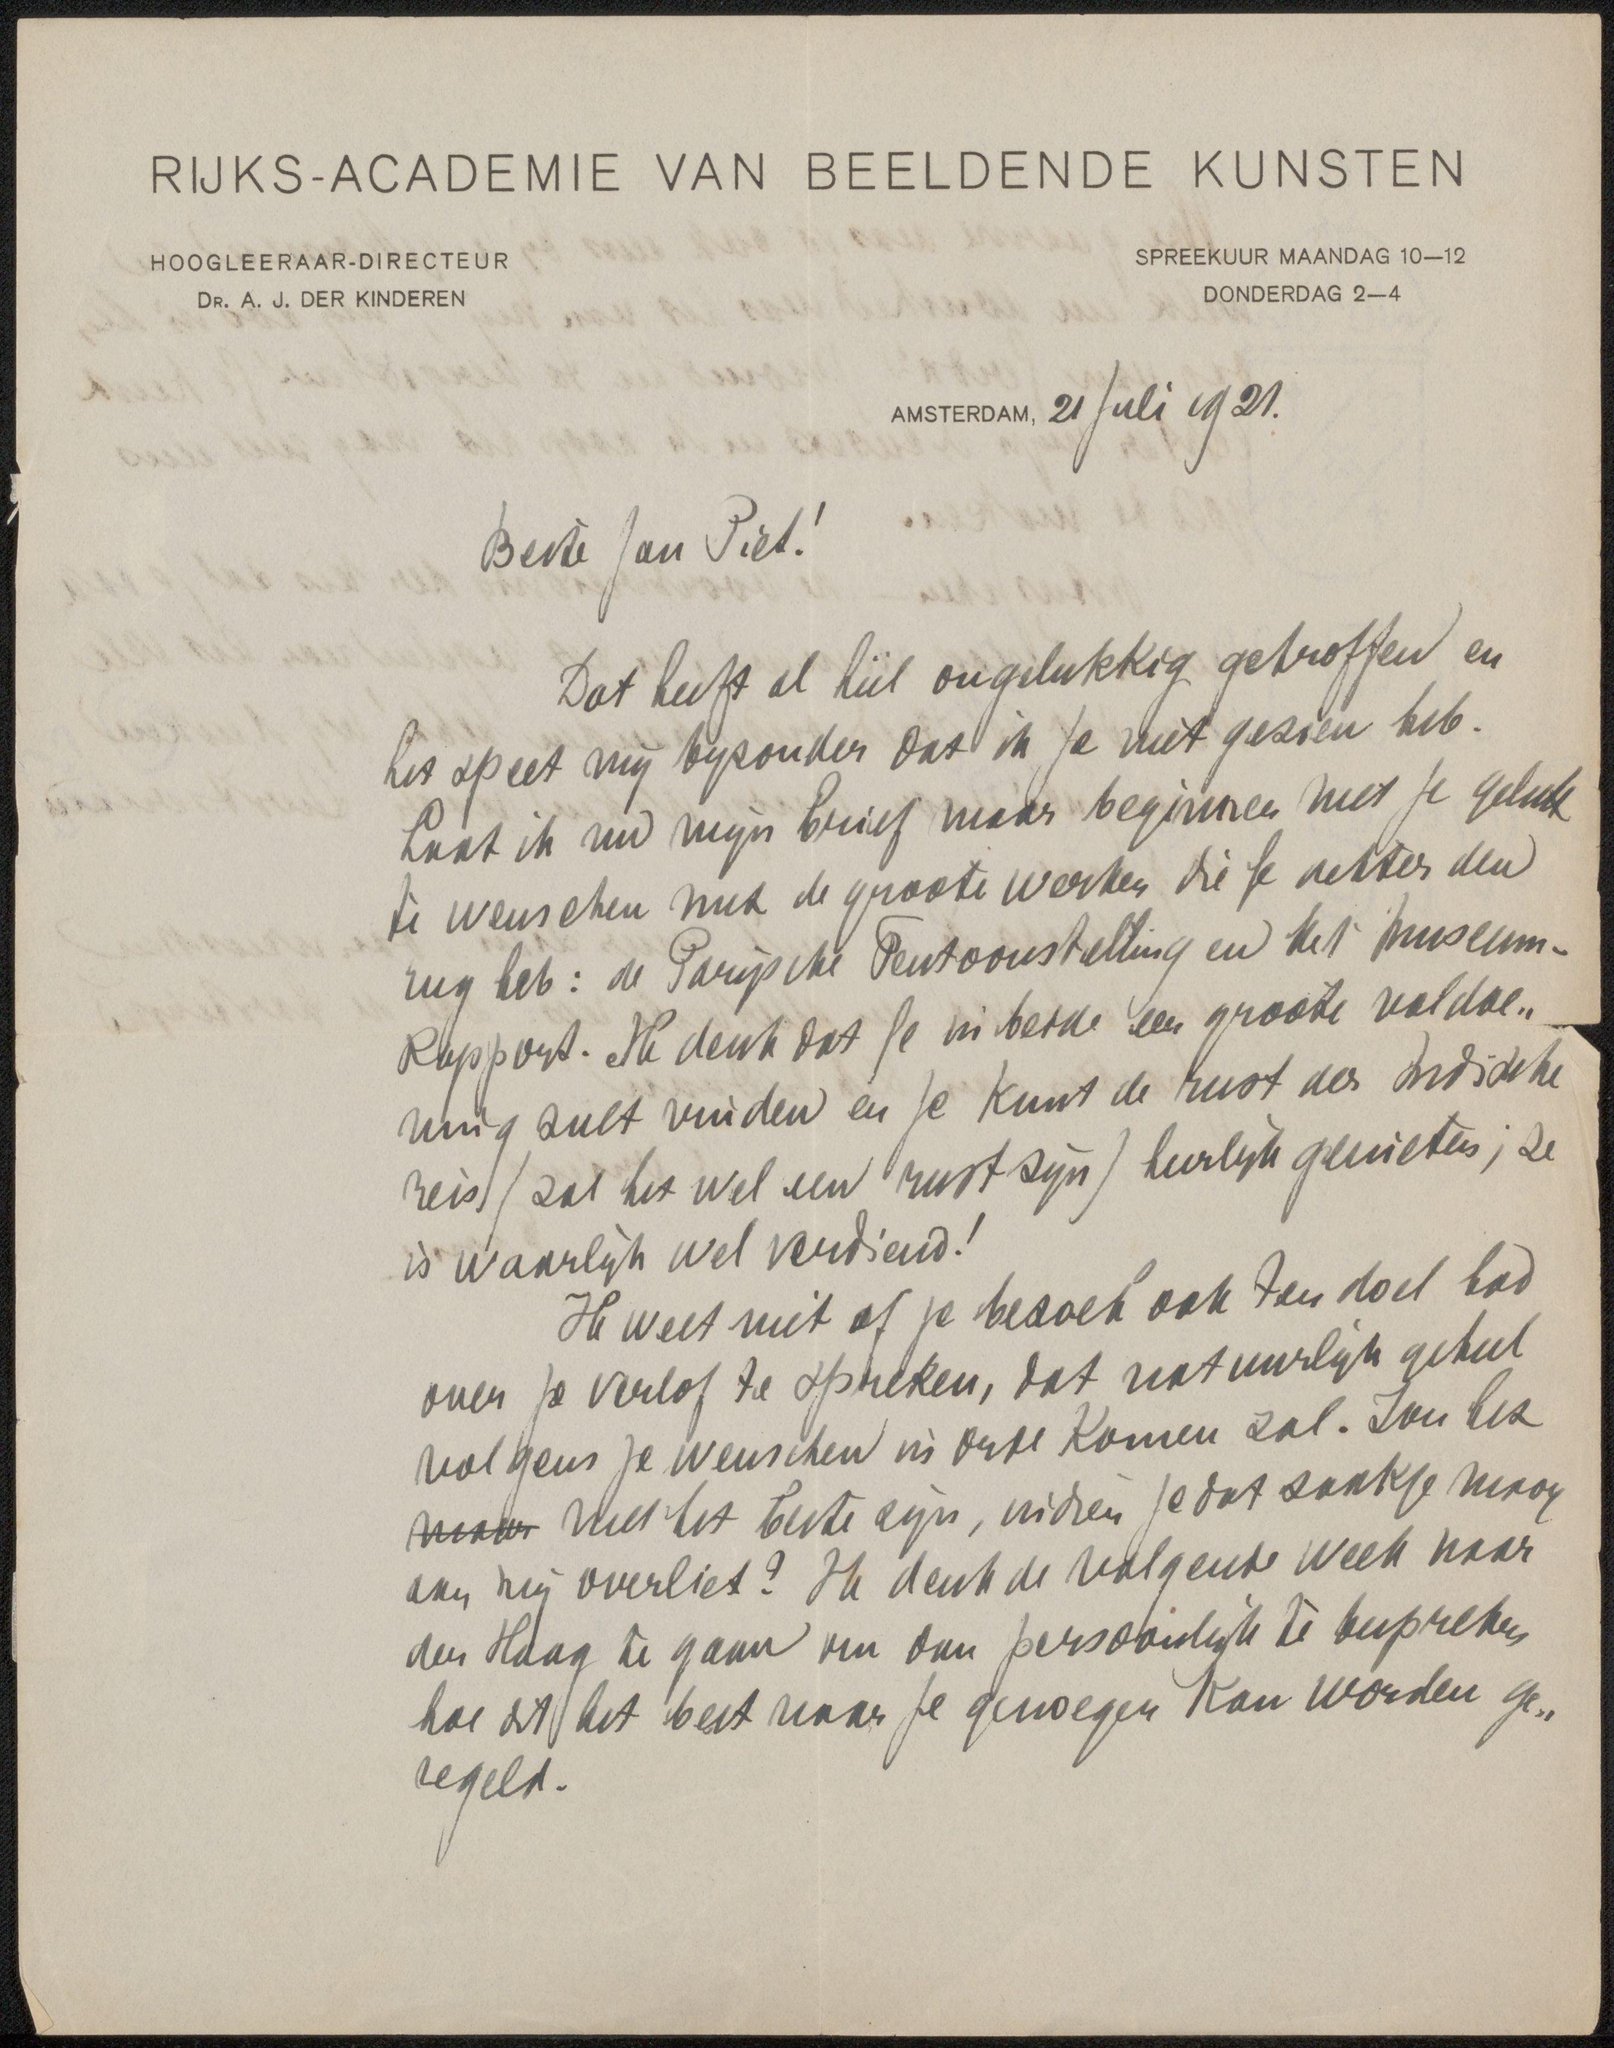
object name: letter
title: Brief aan Jan Veth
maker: antoon derkinderen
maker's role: draughtsman, painter, print maker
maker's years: 1859-1925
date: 1921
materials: ink, paper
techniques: pen, printing, writing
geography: amsterdam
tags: painter, draughtsman, designer, jan veth, travelling; tourism, exhibition ~ art, dutch east indies, the, paris, switzerland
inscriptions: collector's mark: ‘RPK’